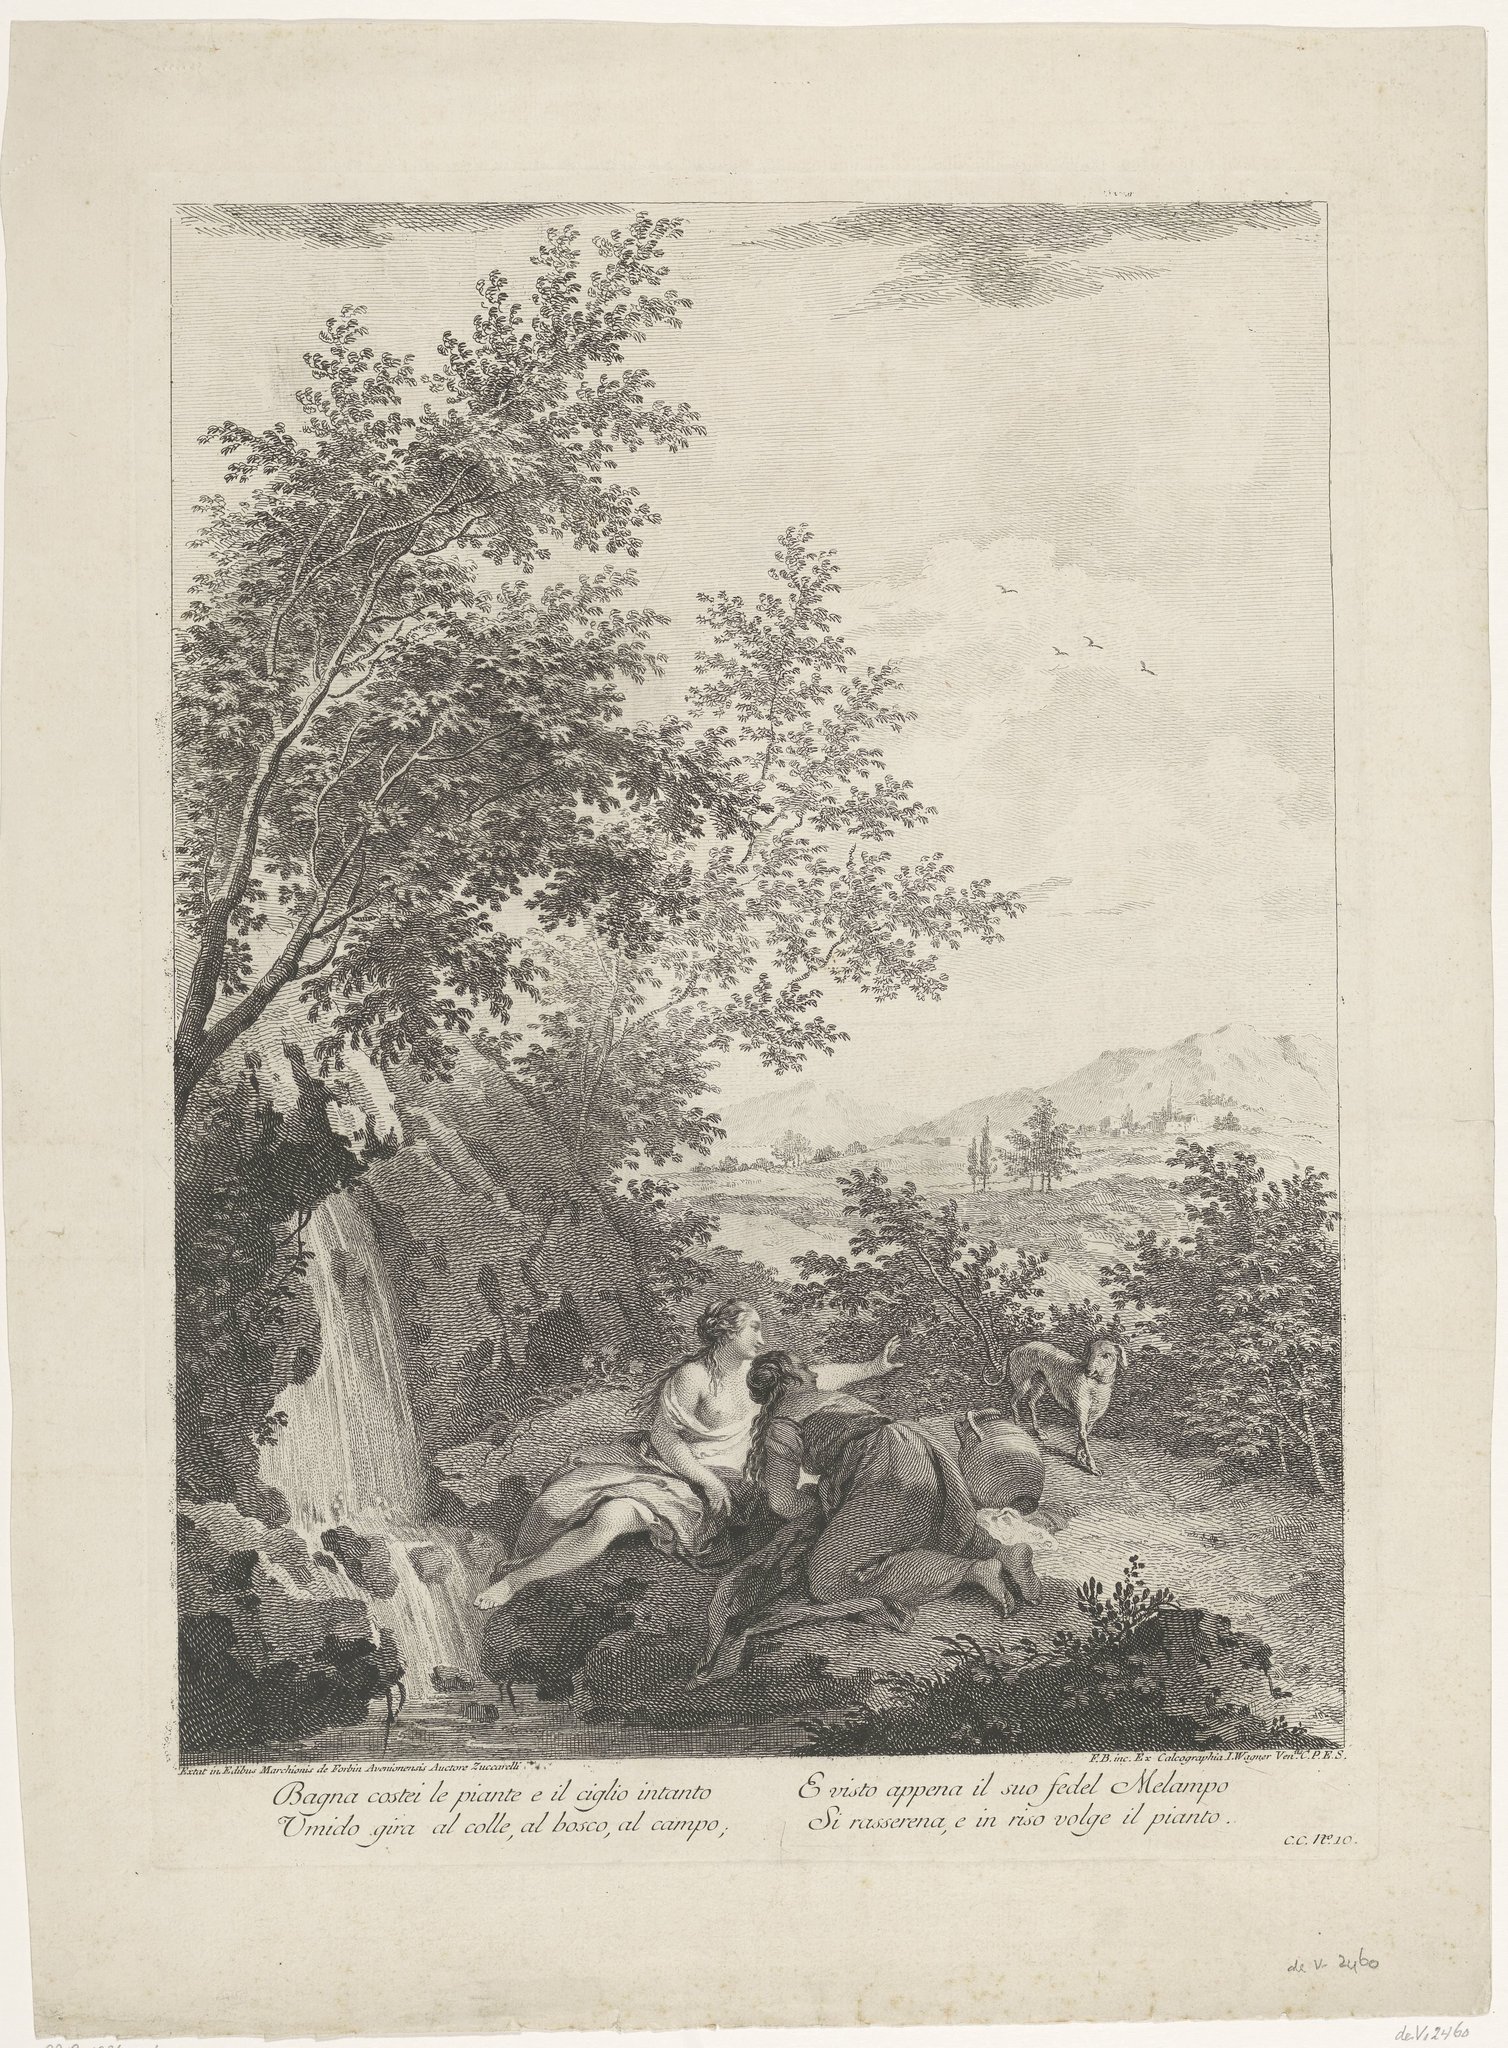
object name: print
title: Landschap met twee vrouwen bij een waterval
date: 1762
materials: paper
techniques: engraving, etching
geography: venice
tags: landscapes, waterfall, dog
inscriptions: collector's mark: Lugt 2228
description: Een landschap met twee vrouwen bij een kleine waterval. De vrouwen kijken om naar een hond die achter hen langs loopt. Italiaans vers in ondermarge. Genummerd rechtsonder: C.C. No. 10.